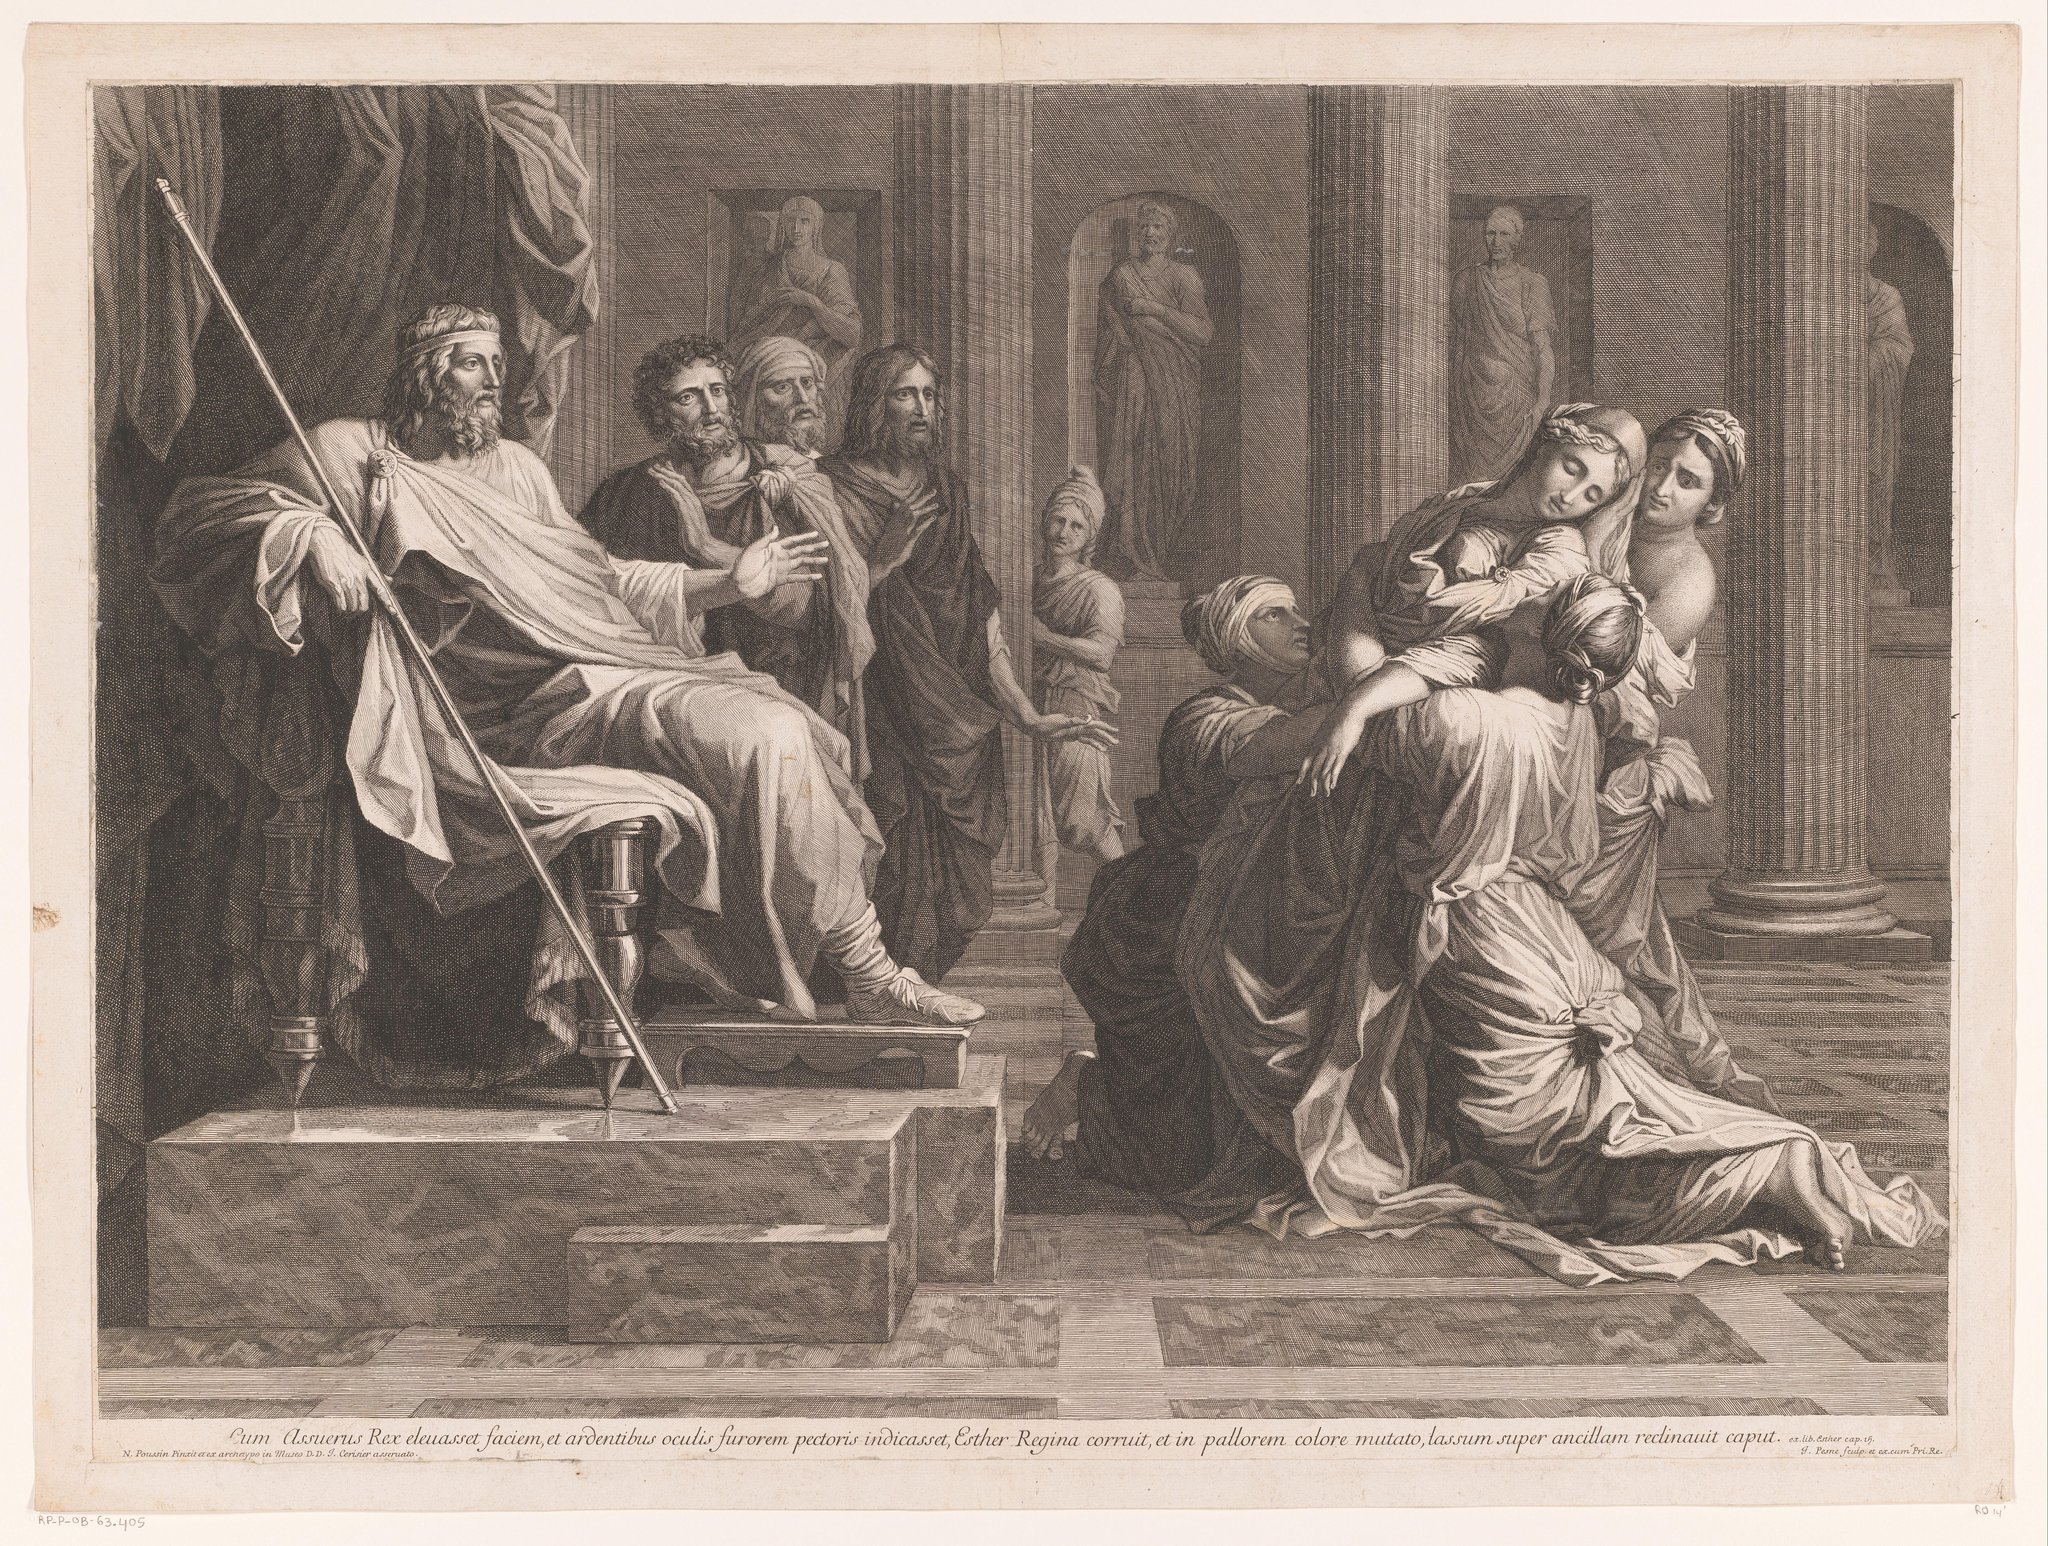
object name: print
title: Esther voor Ahasveros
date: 1643-1700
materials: paper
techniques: engraving, etching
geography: france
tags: esther swoons on the shoulder of one of her maids (esther 15:7)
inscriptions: collector's mark: Lugt 240